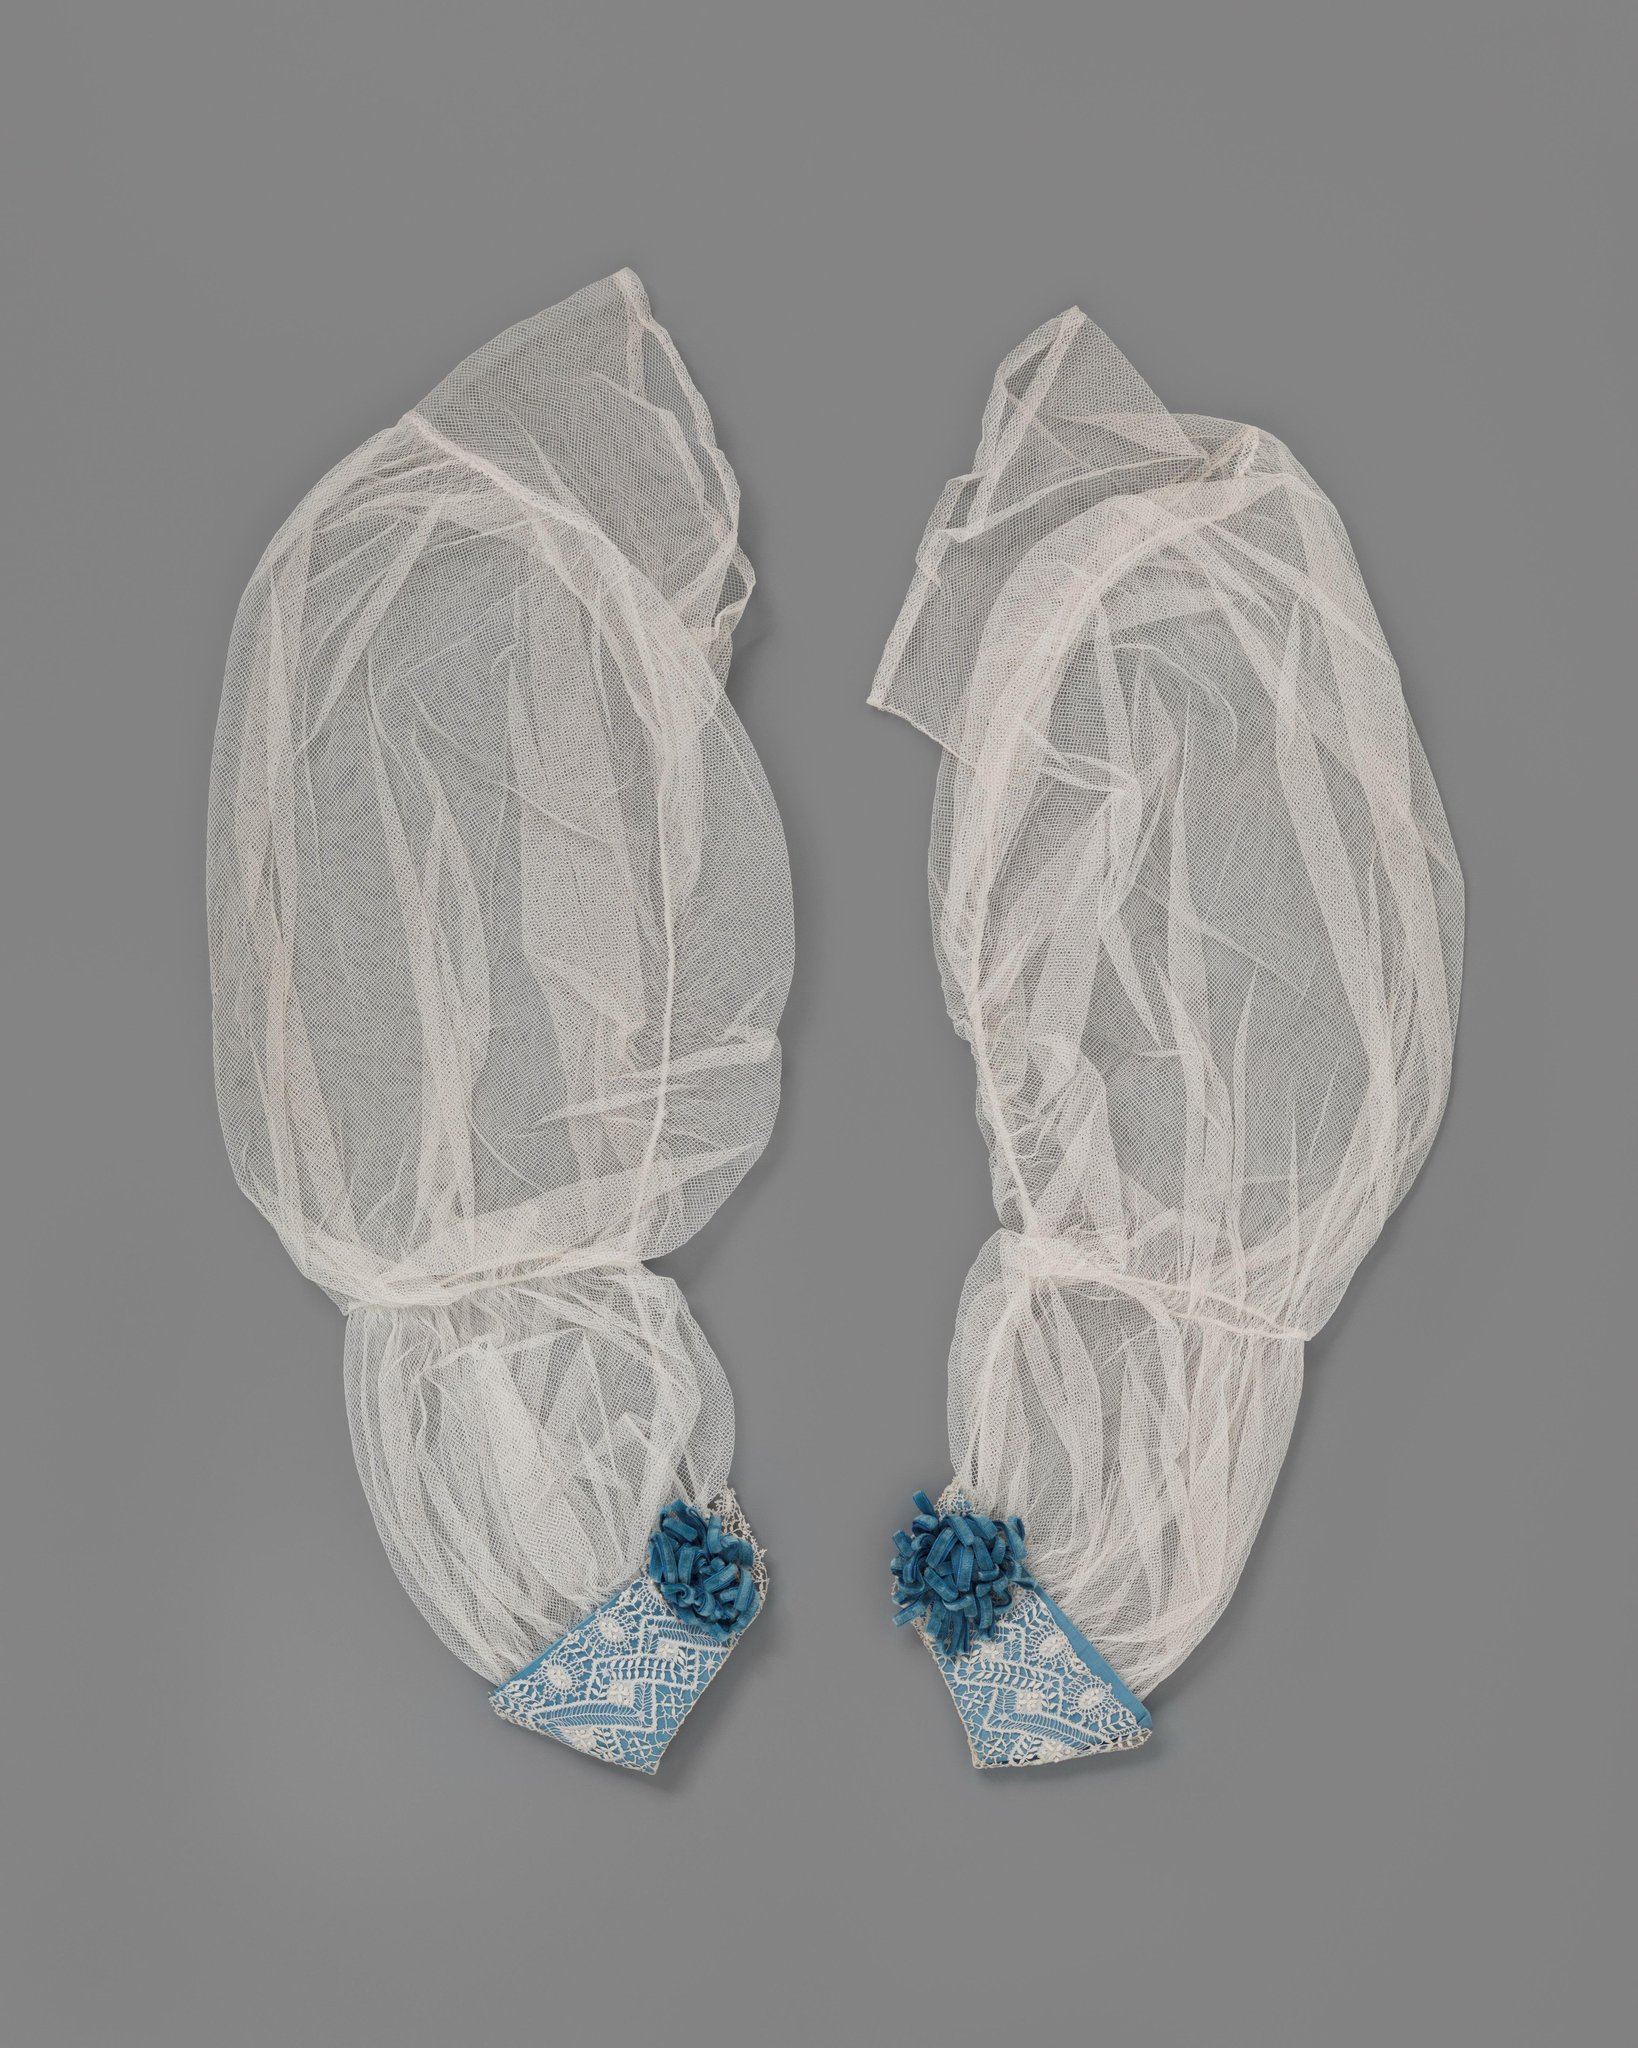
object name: womenswear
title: Ondermouw van machinale tule met manchet van Clunykant en versierd met blauw lint en fluweel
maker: Anonymous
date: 1860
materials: mother of pearl, ribbon, velvet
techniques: lace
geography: france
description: Ondermouw van machinale tule met manchet van Cluny kloskant en versierd met blauw lint en fluweeltje. Model. Ballonmouw, die halvewege eenmaal is ingesnoerd. Glad, puntig, omslagmanchetje van kant, met blauw ripslint onderlegd, en met een pompoen van blauwe fluwelen lintjes bovenop. Kant. Type Cluny met reliëfblaadjes, linnenslag en een fond van spijlen.